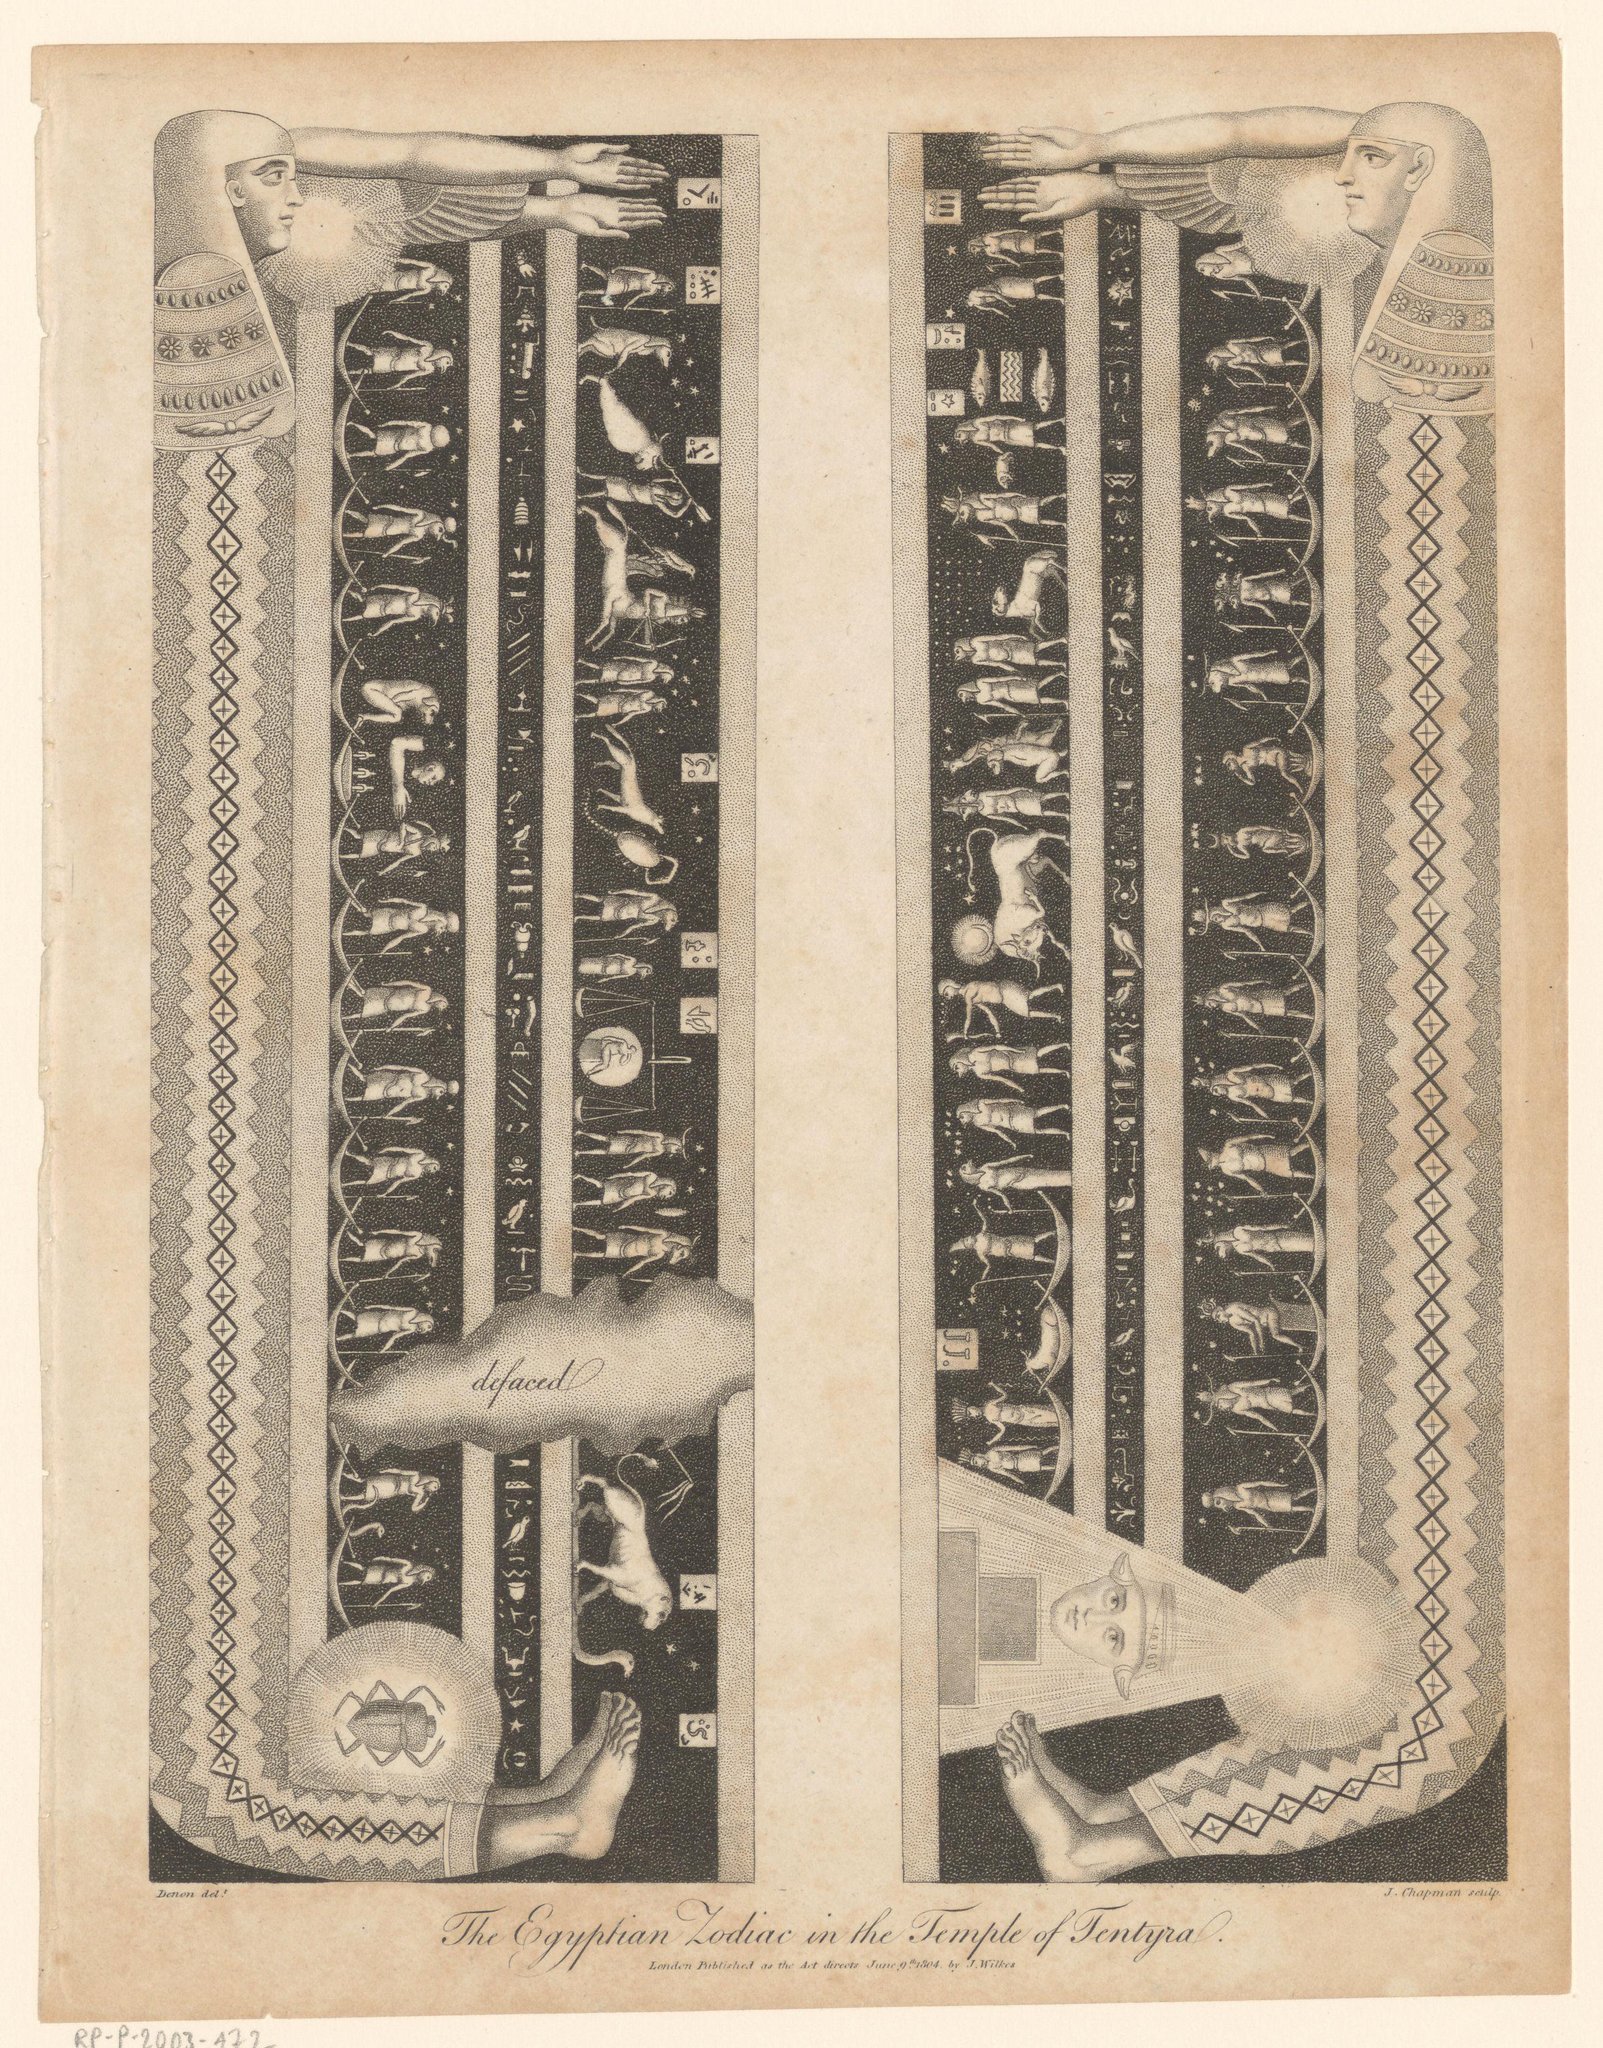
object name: print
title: Egyptische sterrenbeelden uit een tempel te Dendera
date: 1804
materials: paper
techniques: etching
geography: london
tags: zodiac; the twelve zodiacal signs together, egyptian hieroglyphs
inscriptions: collector's mark: Lugt 2228